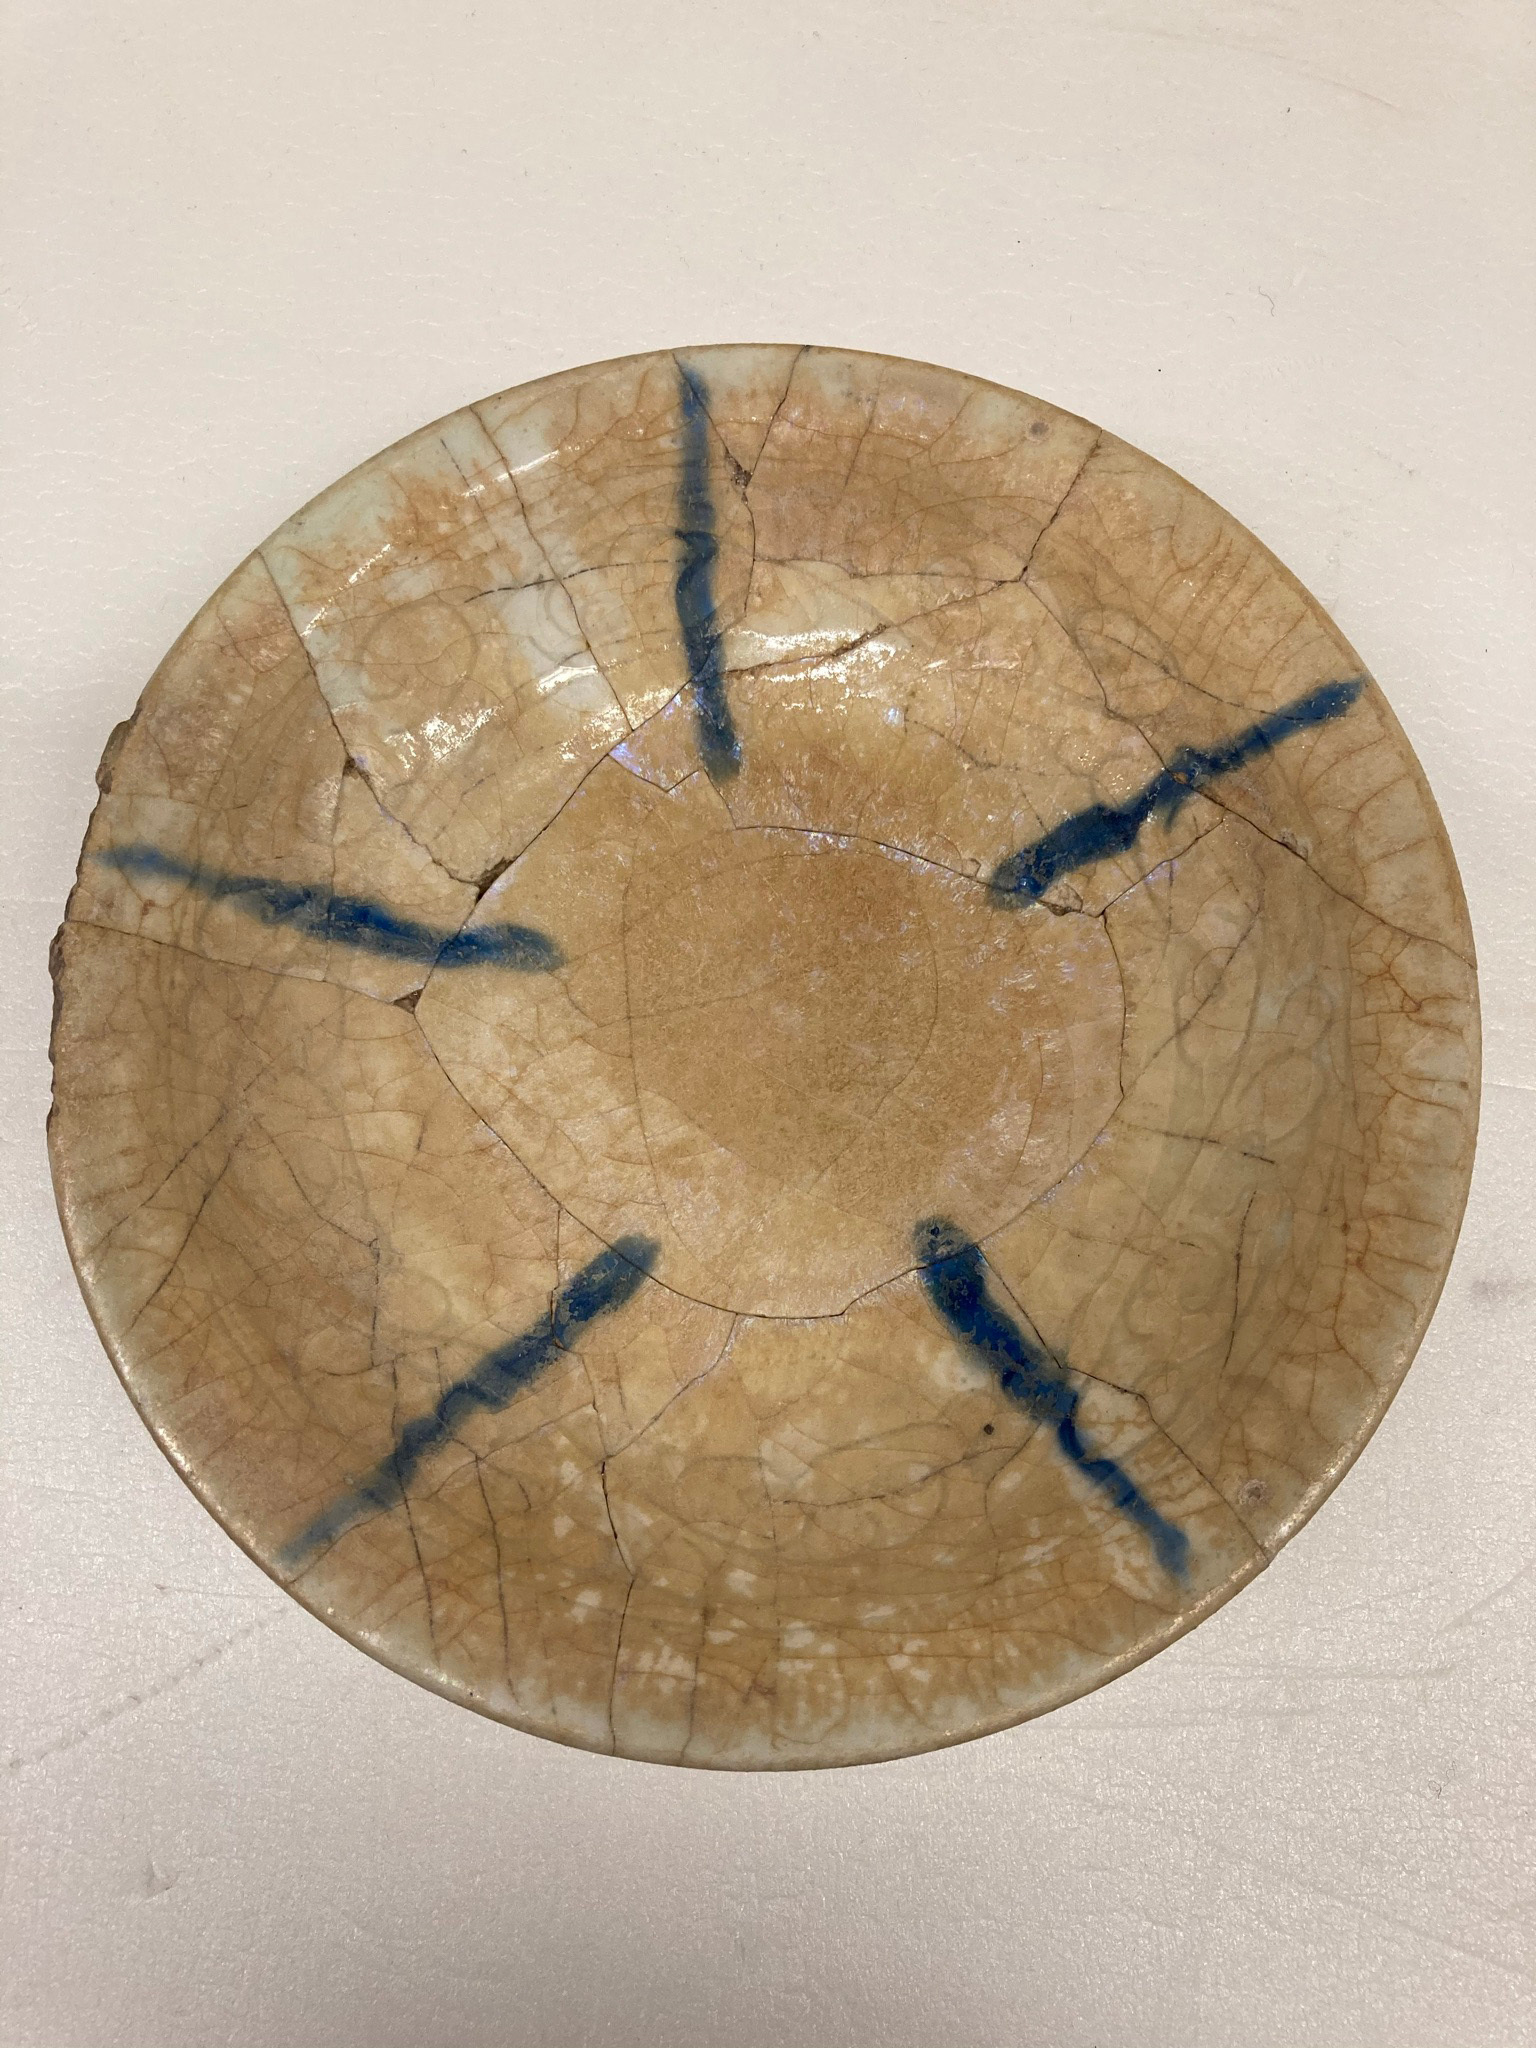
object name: plate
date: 1001-1100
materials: earthenware, glaze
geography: iran